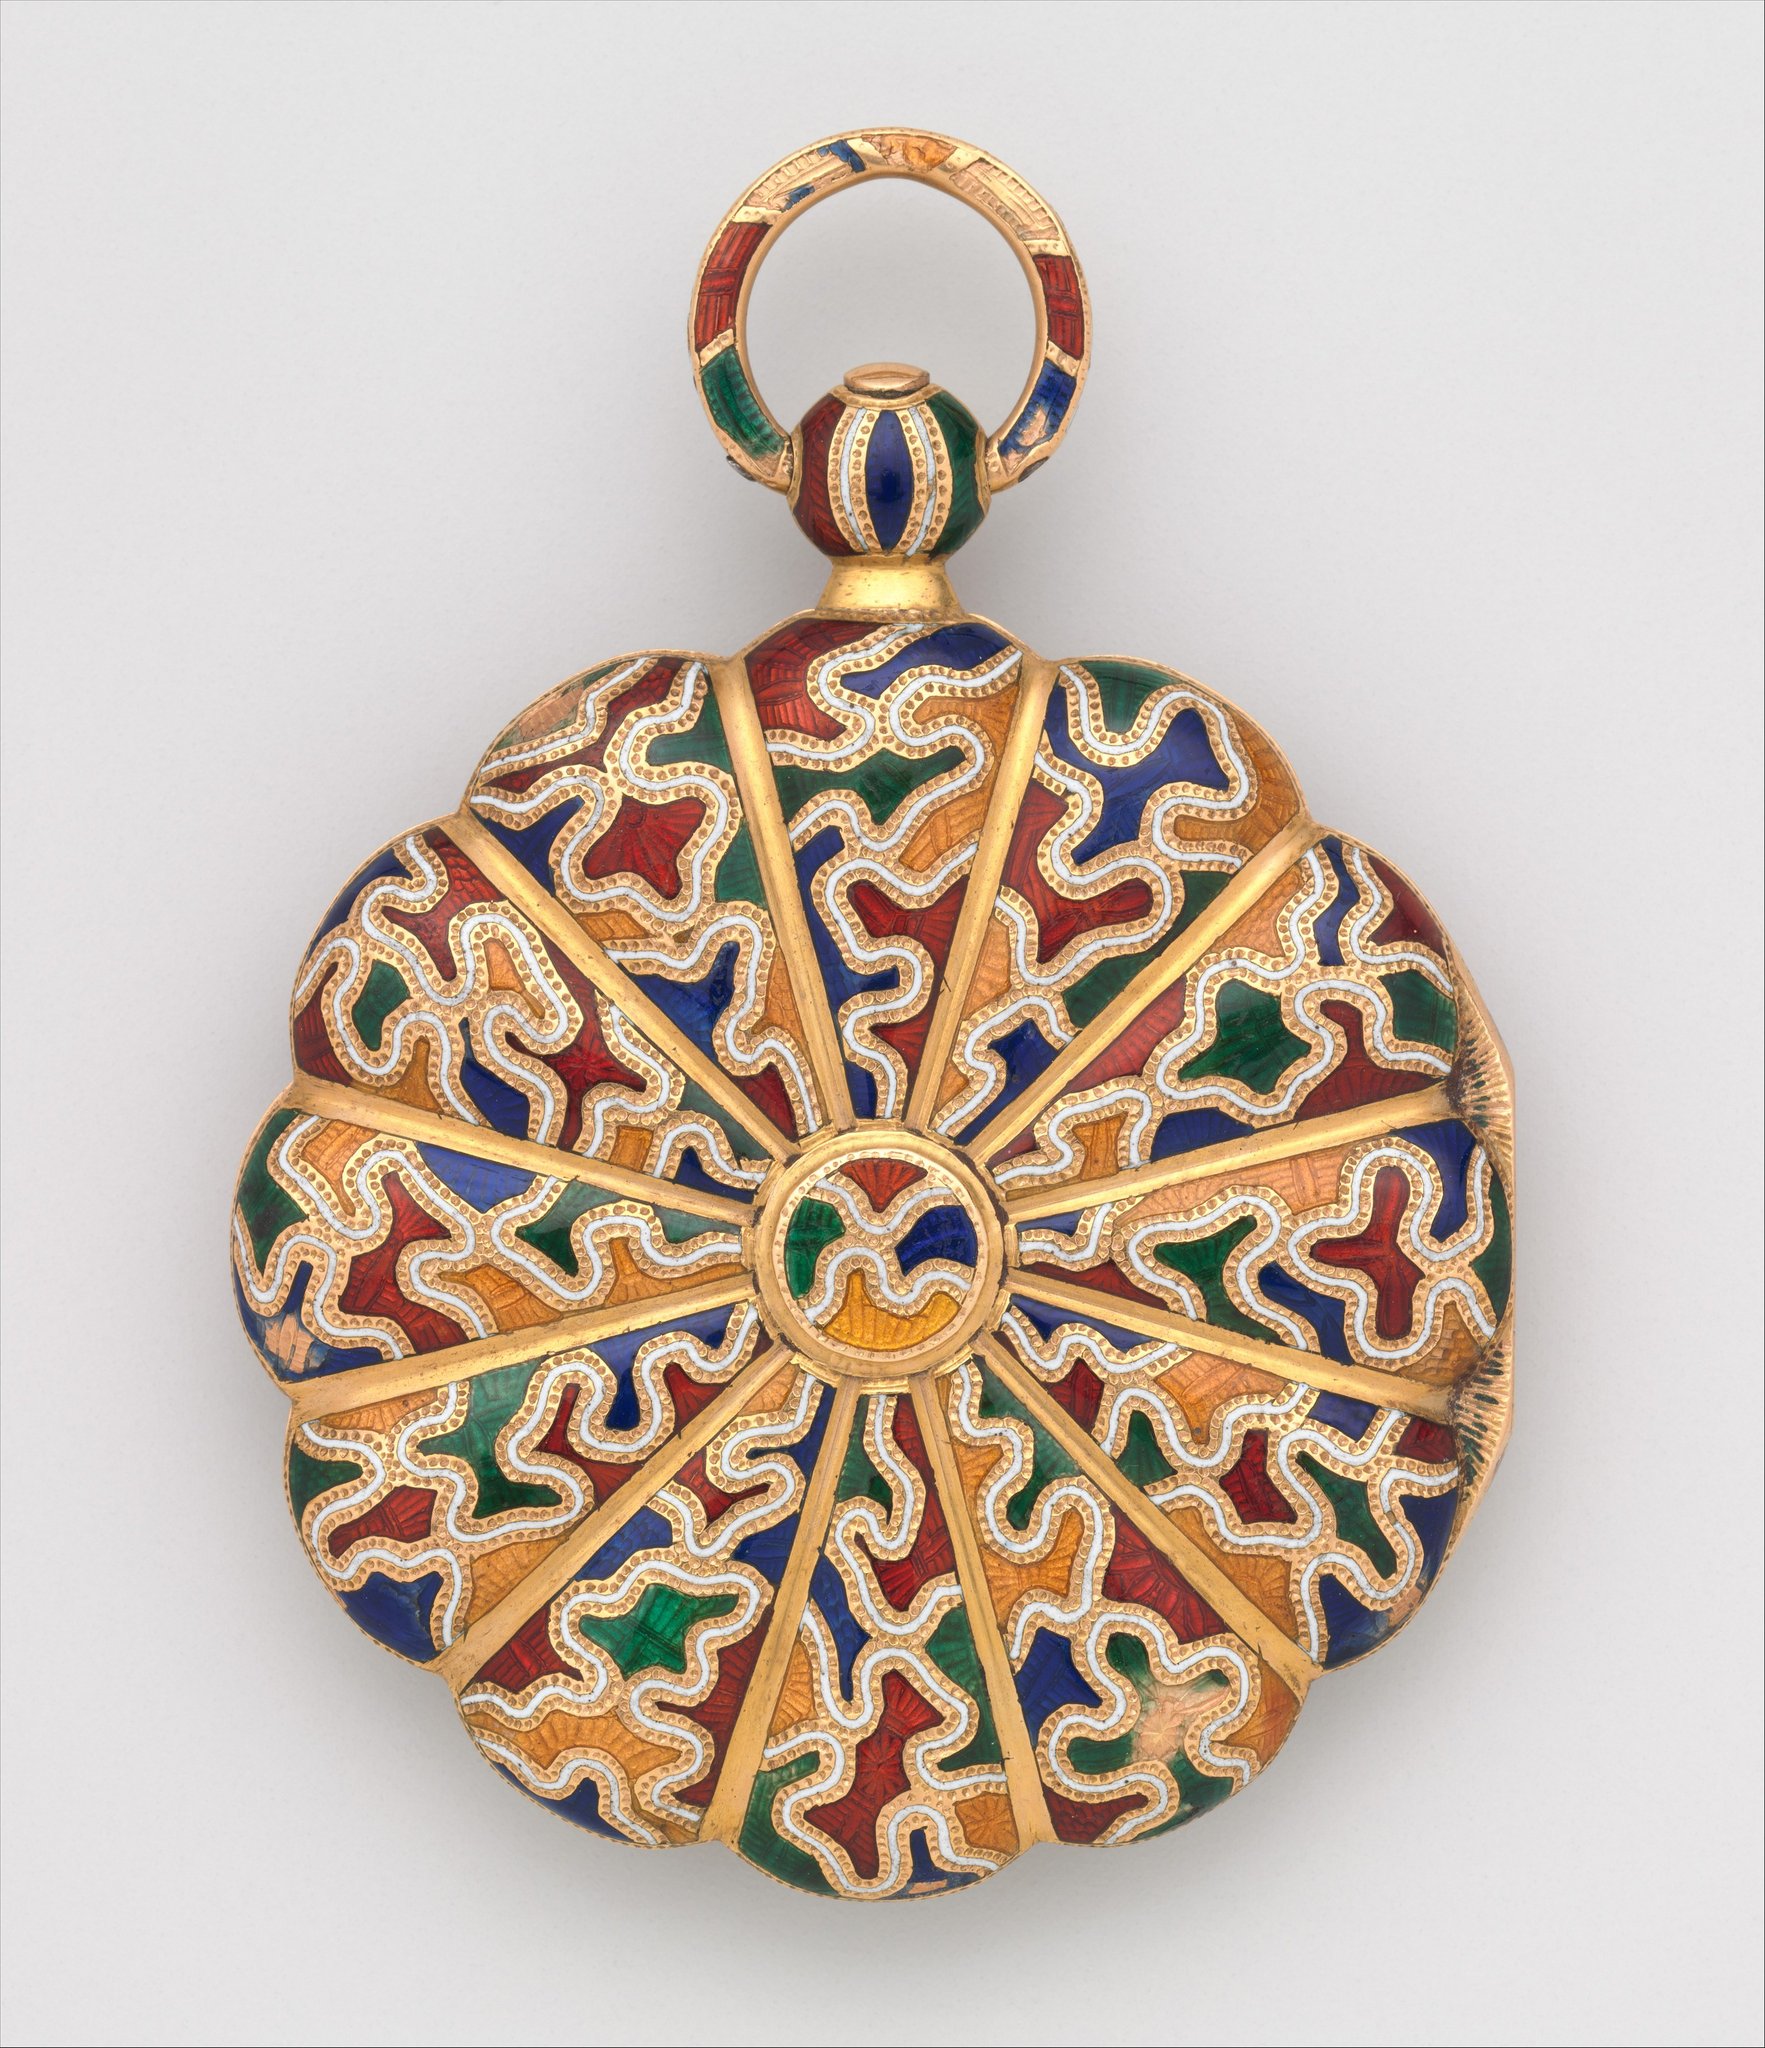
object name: watch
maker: firm of moynier & fils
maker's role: maker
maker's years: 1830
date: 1825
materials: enamel, gold